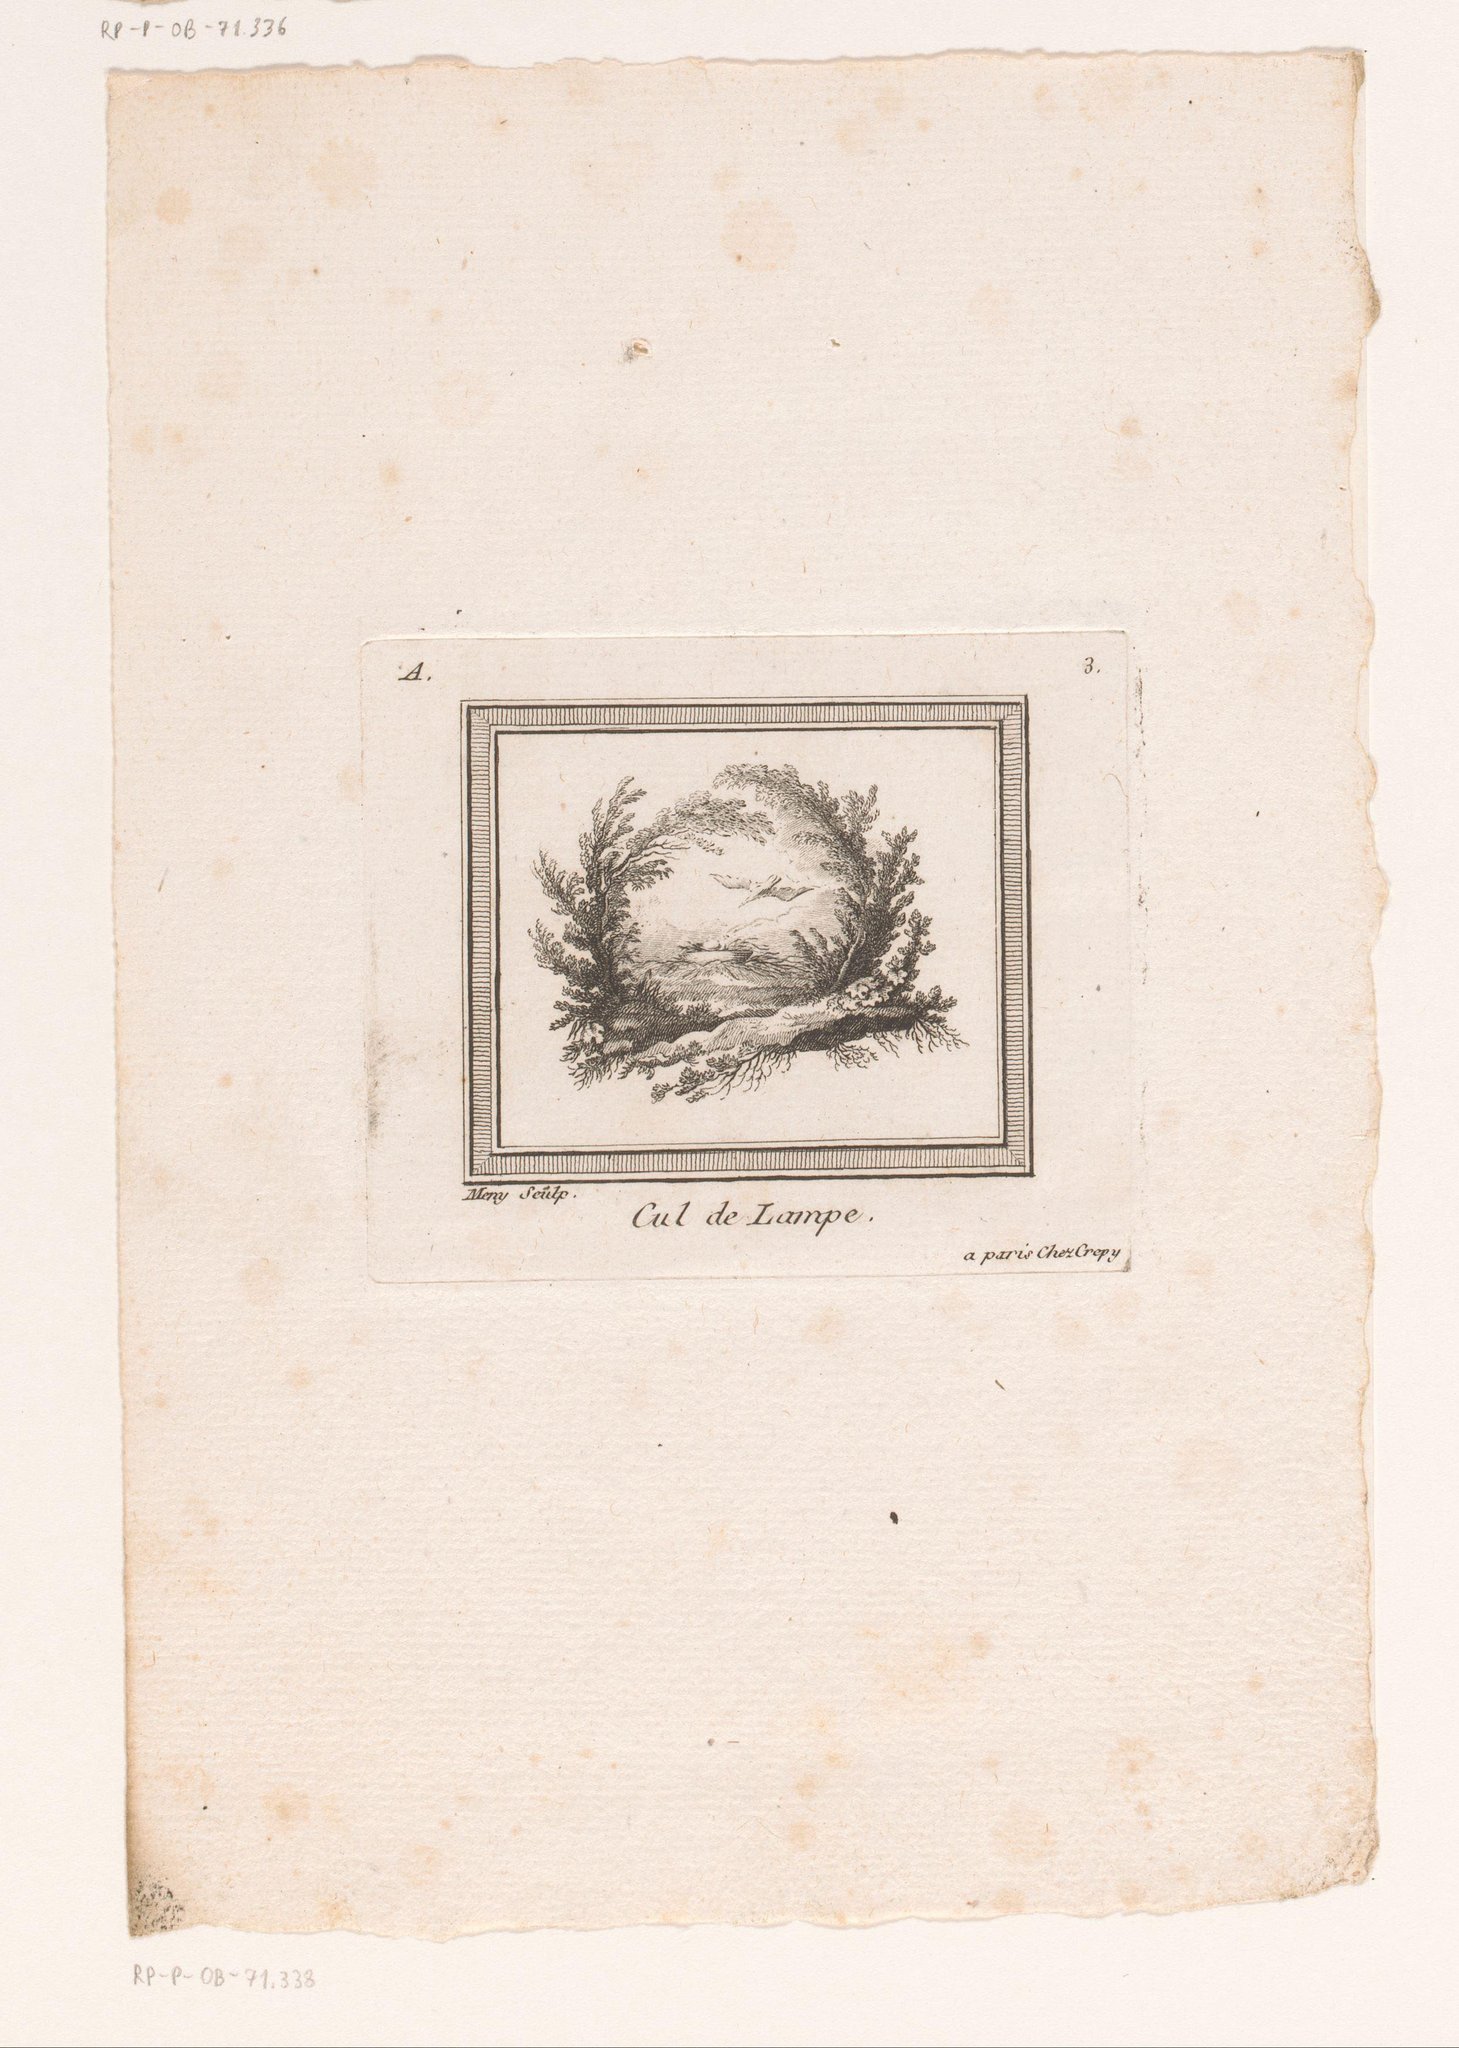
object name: print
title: Vignet met vogel en zijn nest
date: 1700-1799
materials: paper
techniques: etching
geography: paris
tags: birds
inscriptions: collector's mark: Lugt 2228